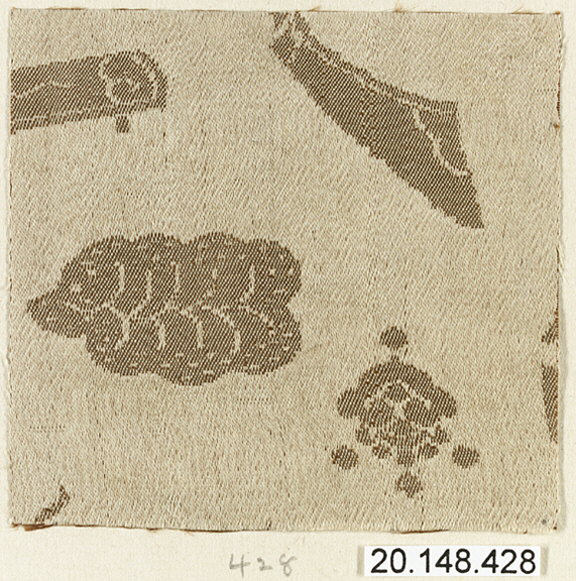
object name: piece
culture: japanese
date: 1701-1800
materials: silk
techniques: compound weave